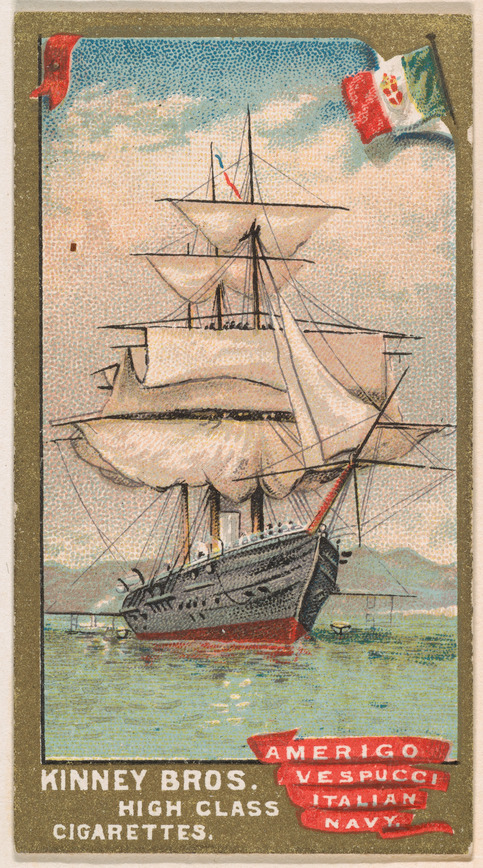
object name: print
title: Amerigo Vespucci, Italian Navy, from the Naval Vessels of the World series (N226) issued by Kinney Bros.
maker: kinney brothers tobacco company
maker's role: publisher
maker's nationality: american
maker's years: 1869-2011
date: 1889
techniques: color lithograph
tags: navy,ships